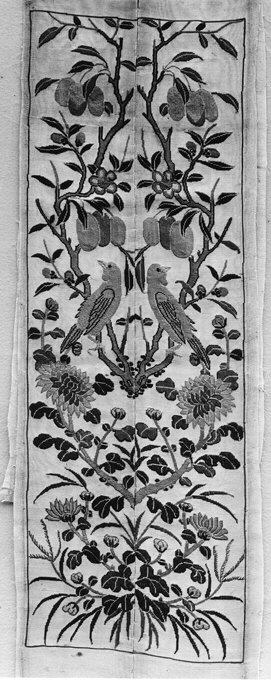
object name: sleeve band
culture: chinese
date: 1801-1900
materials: silk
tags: birds,flowers